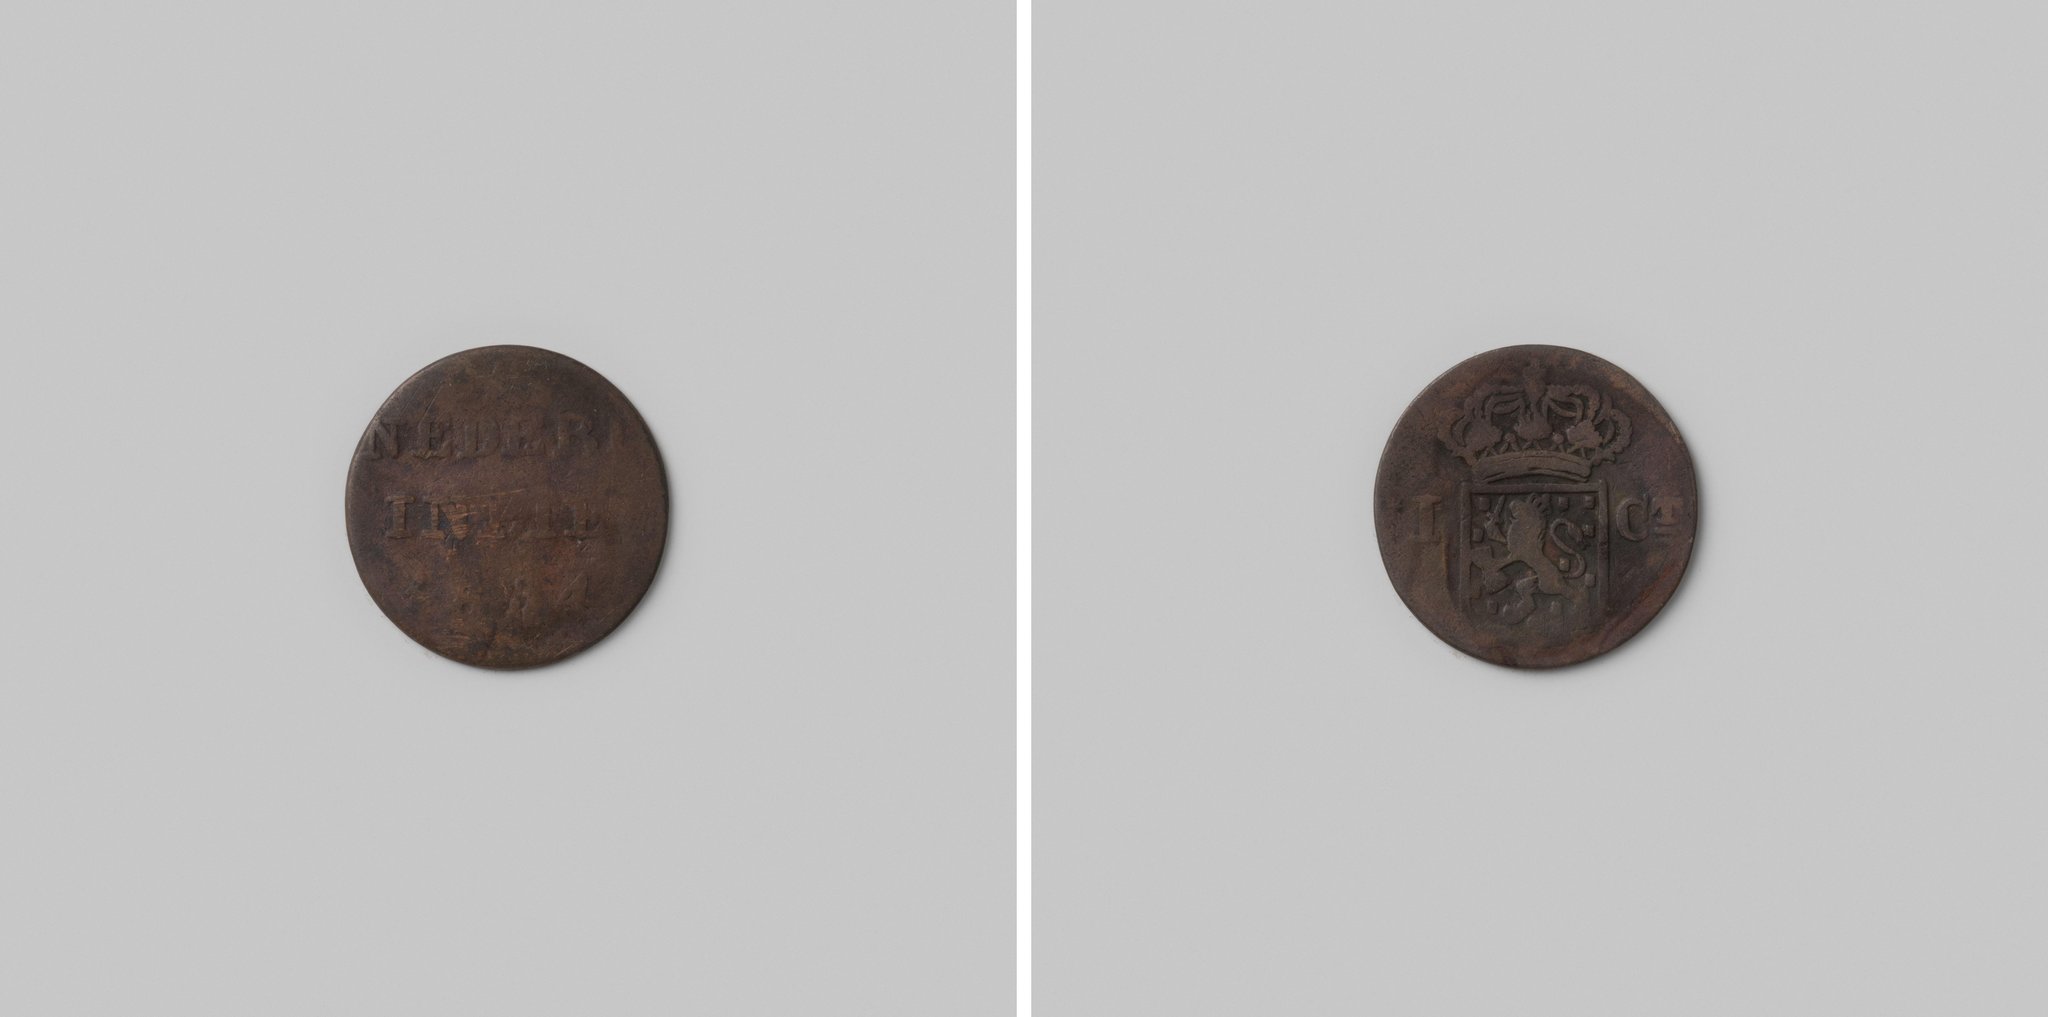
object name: coin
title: Koperen 1 cent muntje uit Nederlands-Indië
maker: Anonymous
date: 1700-1900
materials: copper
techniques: striking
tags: dutch east indies, the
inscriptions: inscription: ‘1 Ct’, inscription: ‘Jacques Schulman / Numismaat / Keizersgracht 448 / Amsterdam-C.’, inscription: ‘NEDERL / INDIE’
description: Koperen muntje van 1 cent uit Nederlands-Indië. Voorzijde: opschrift. Keezijde: gekroond wapen met leeuw erin. Links van het wapen een 1 en rechts van het wapen een Ct. Het muntje zit in een envelopje met opschrift.